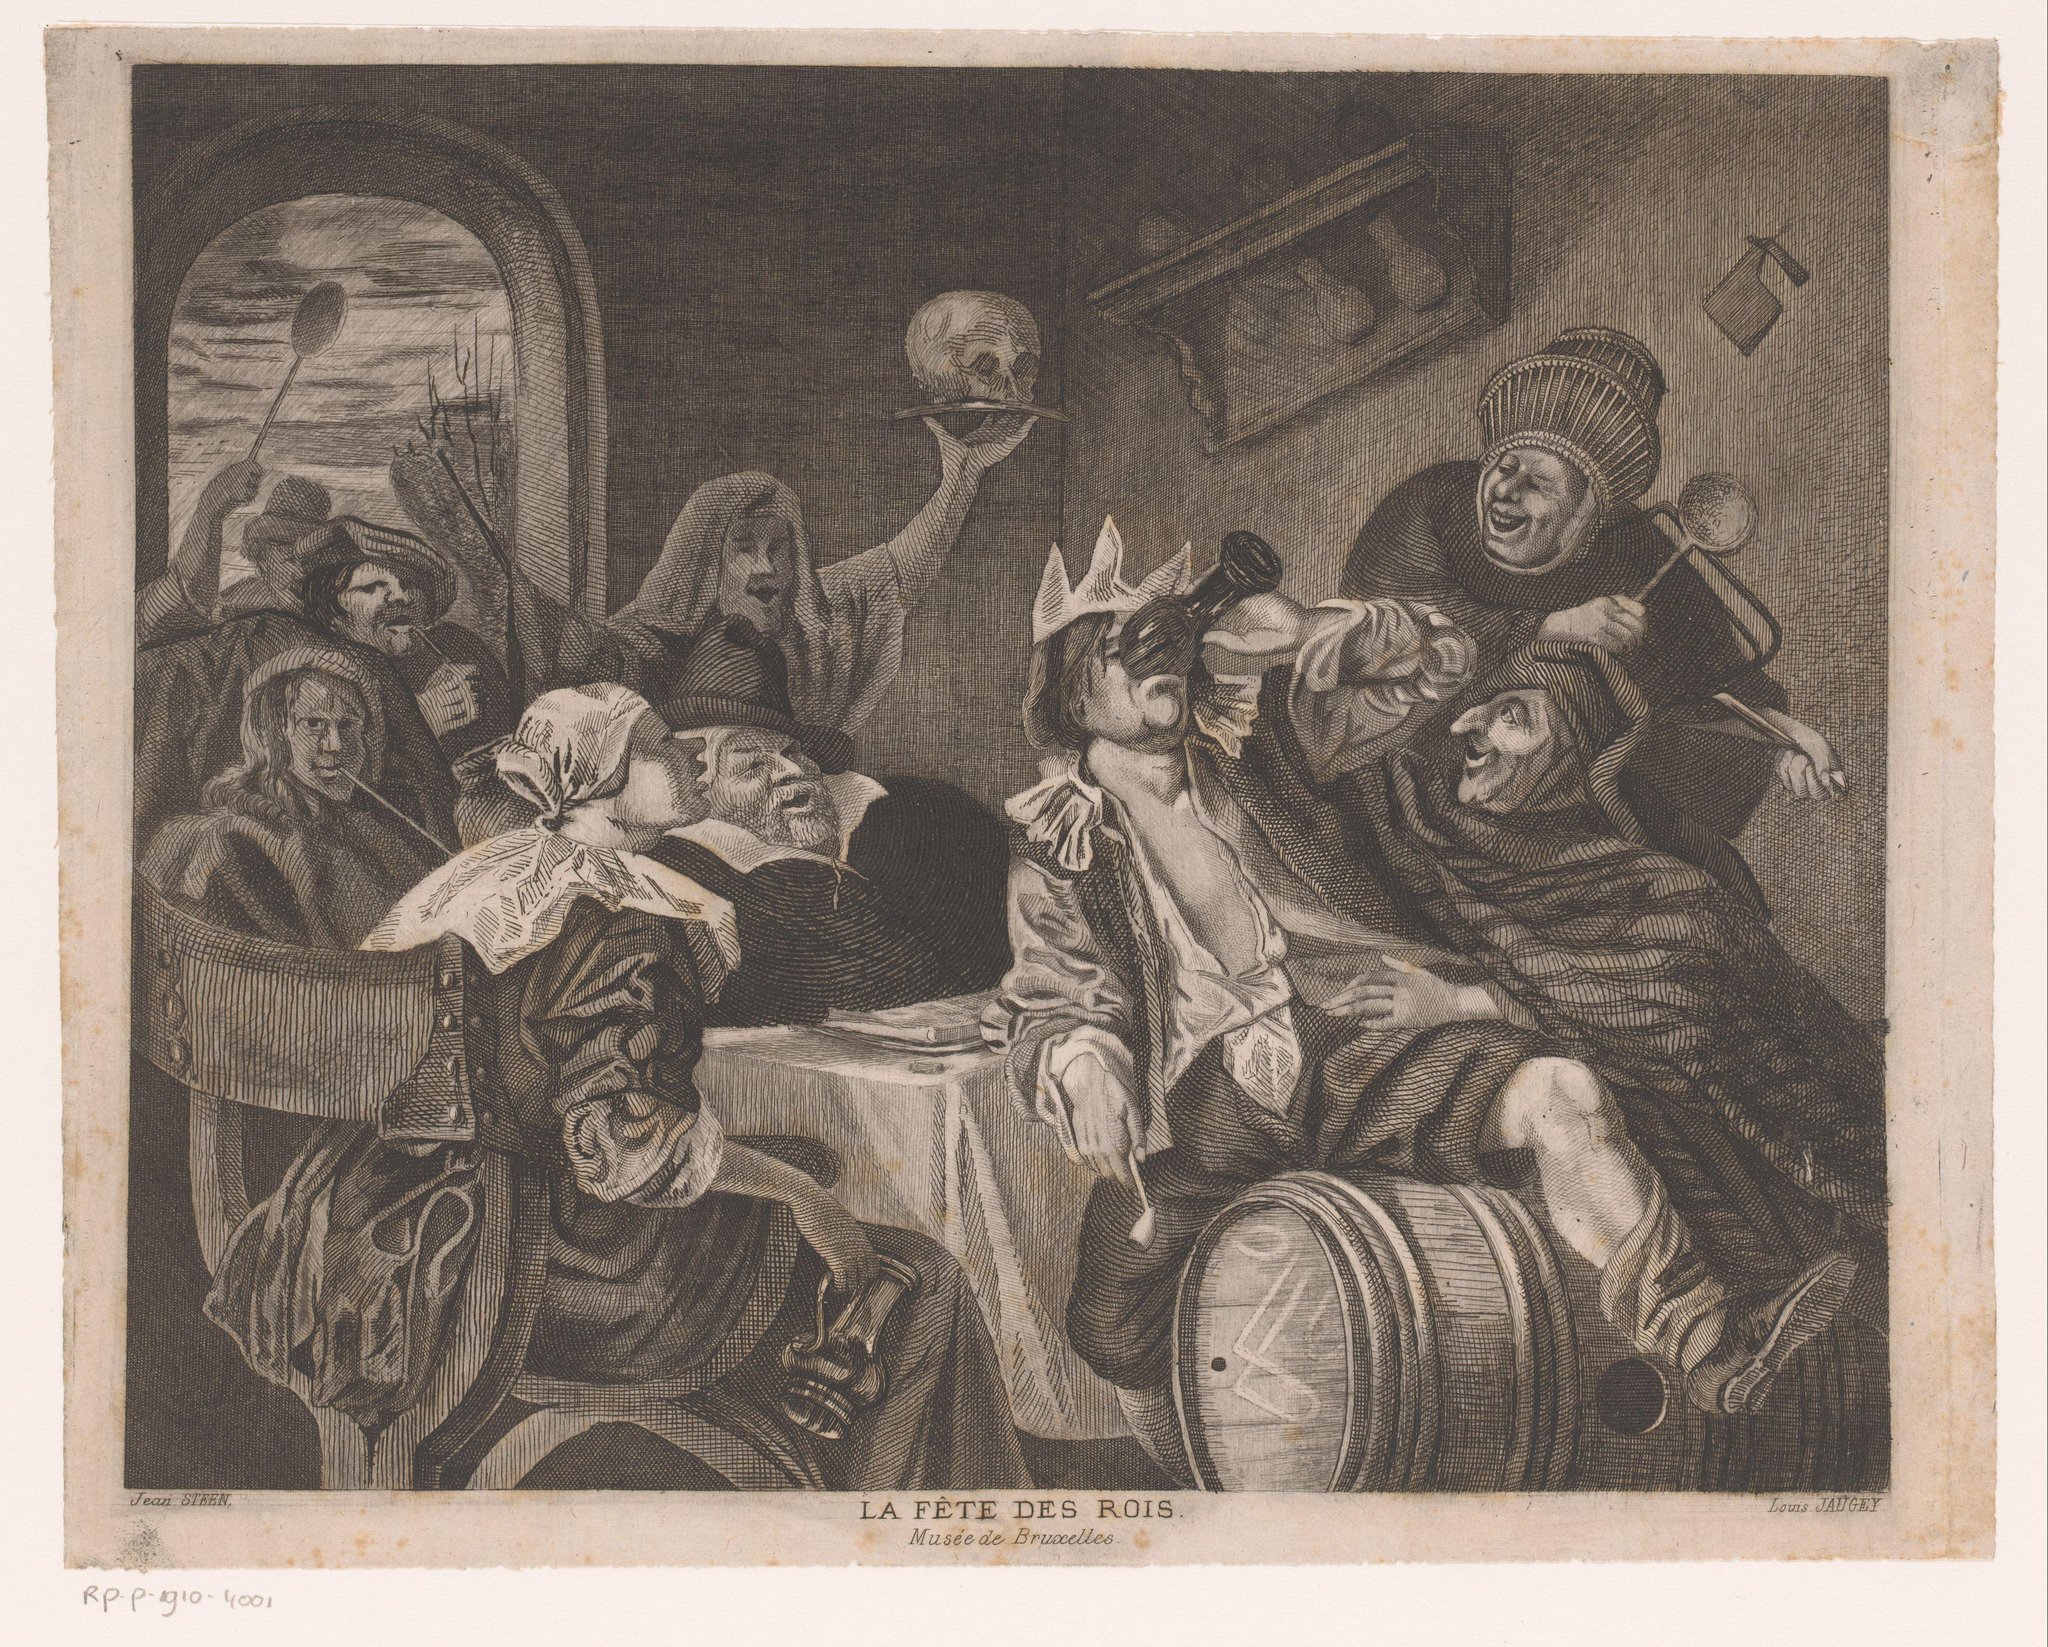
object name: print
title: Driekoningenfeest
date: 1850-1899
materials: paper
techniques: etching, intaglio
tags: feasts of saints (and their relics), periodic celebrations, popular feasts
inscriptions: collector's mark: Lugt 2228